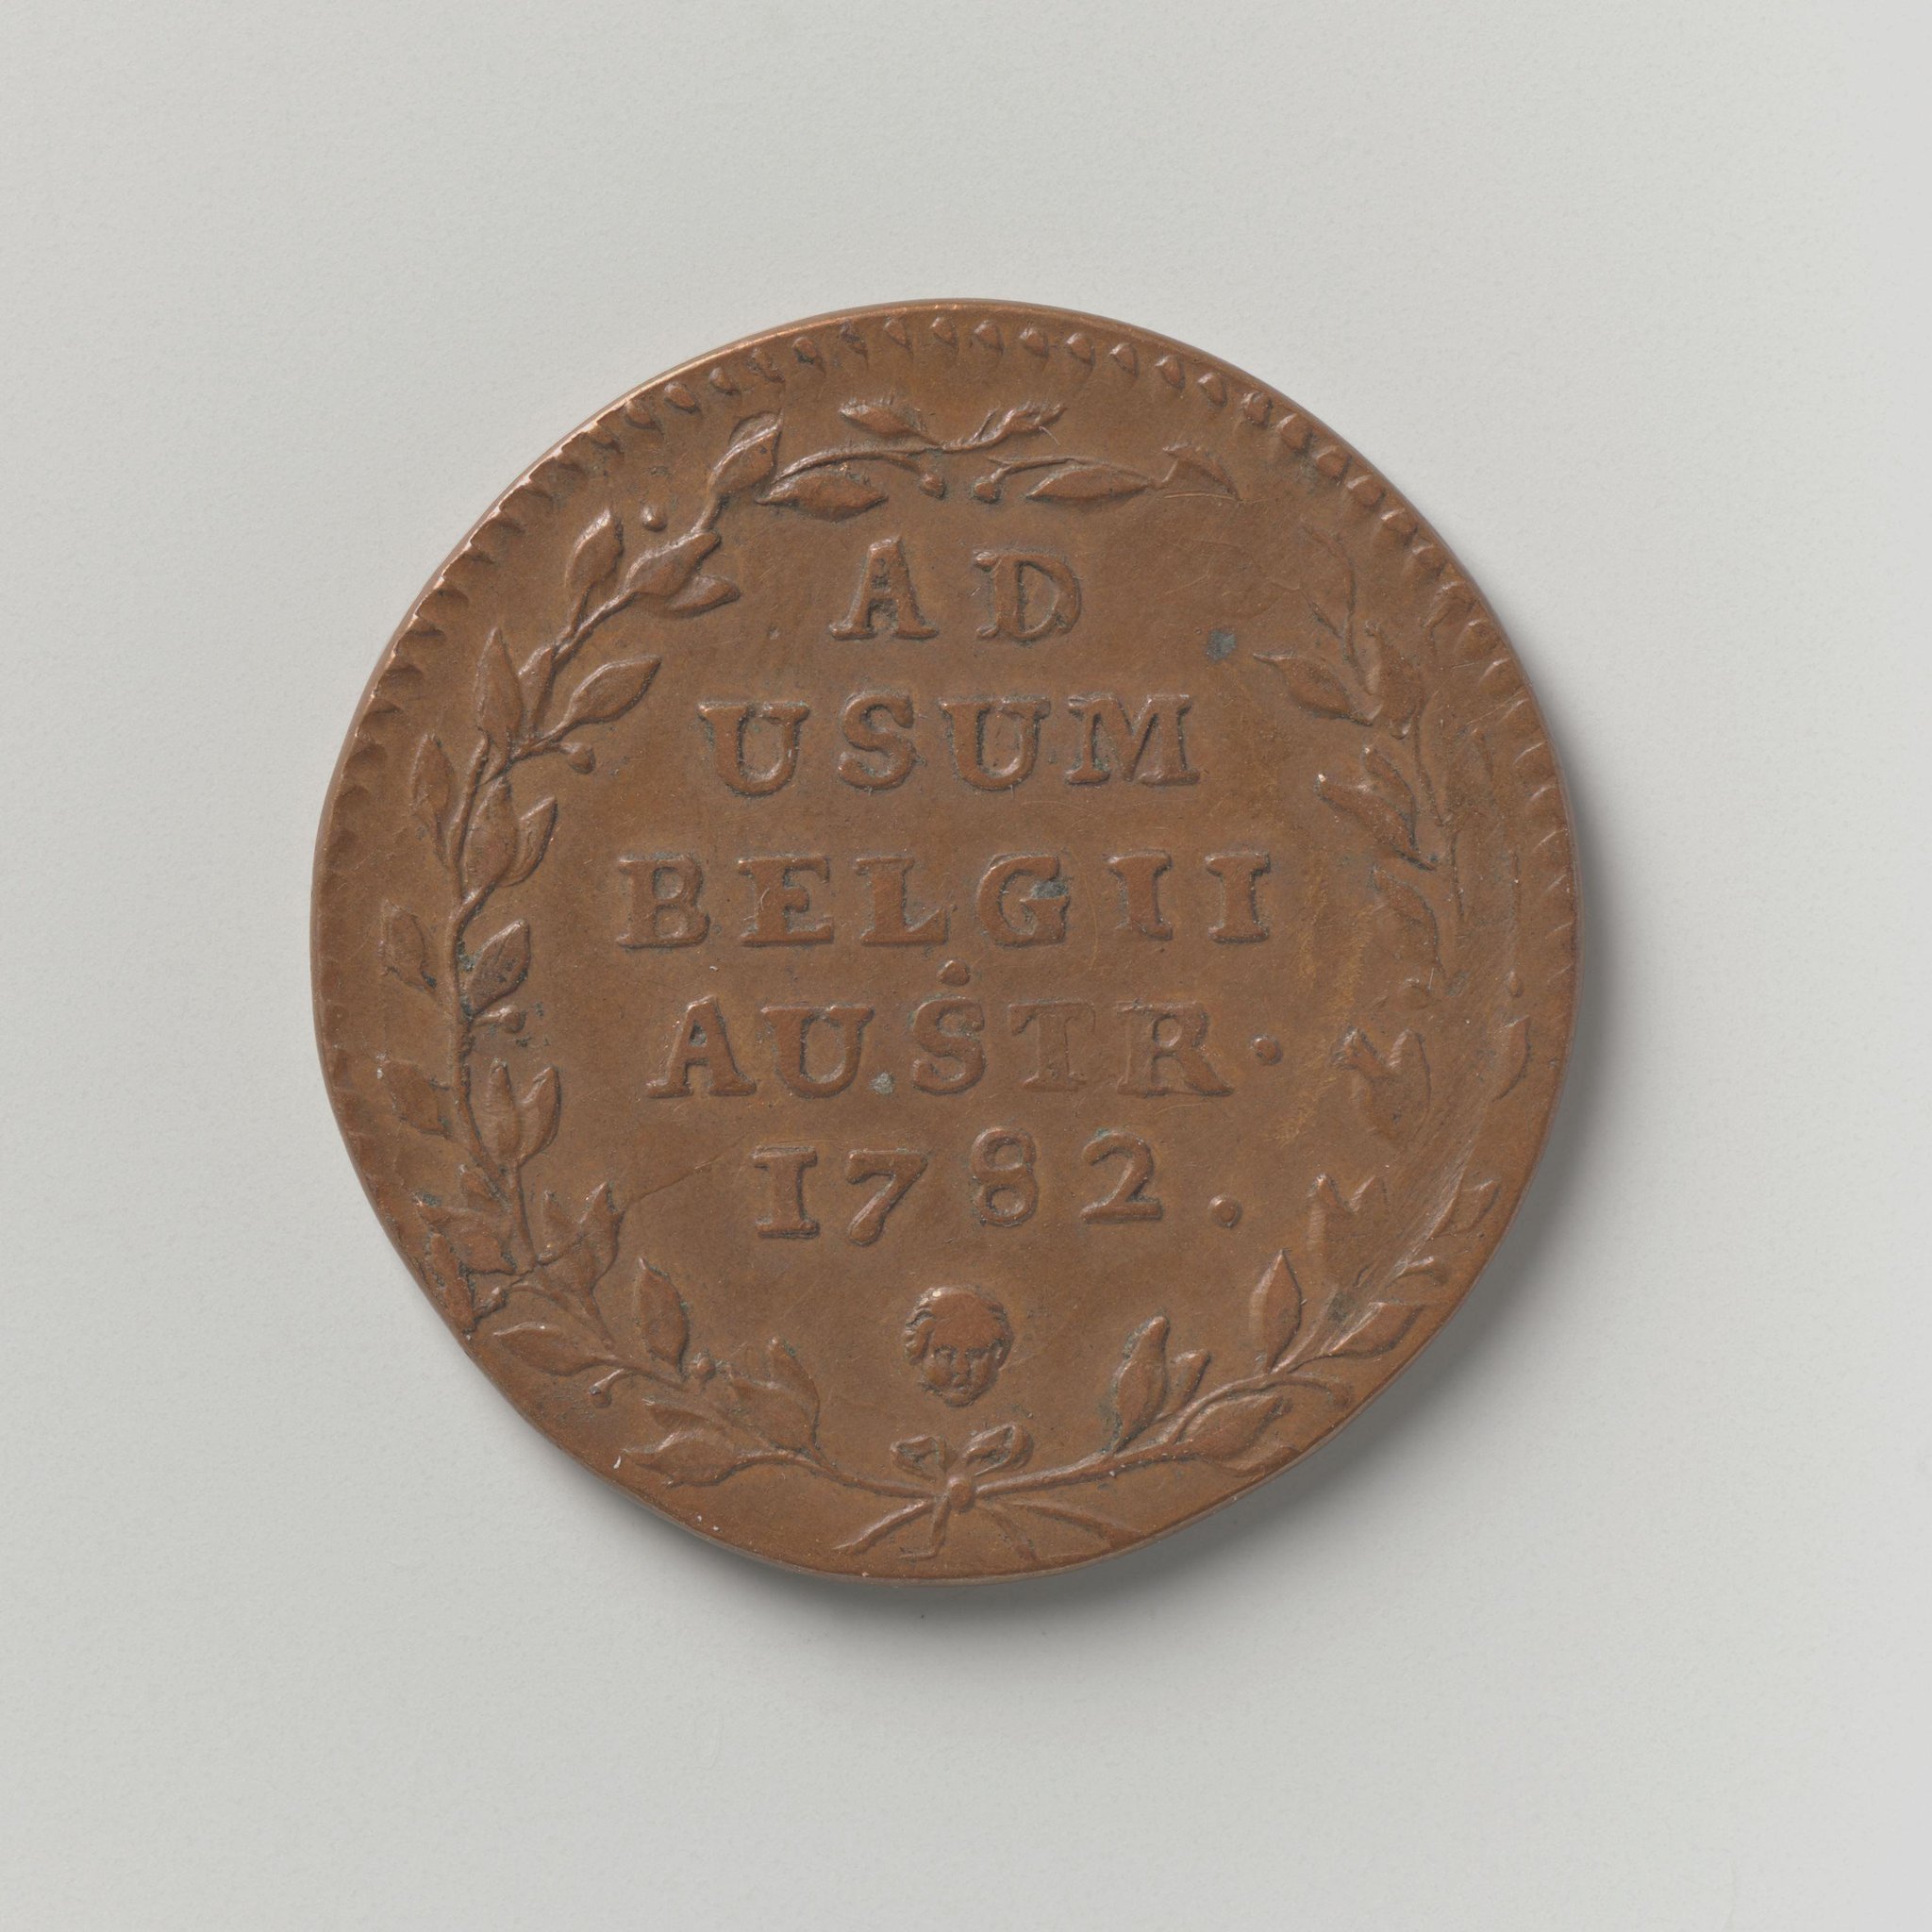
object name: coin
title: Dubbele oord uit Brabant van Jozef II,1782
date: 1782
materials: copper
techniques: striking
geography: antwerp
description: Koperen munt. Voorzijde: portret van Jozef II naar rechts. Keerzijde: binnen twee samengebonden lauwertakken vierregelig opschrift, waaronder jaartal. Daaronder engelenkop.